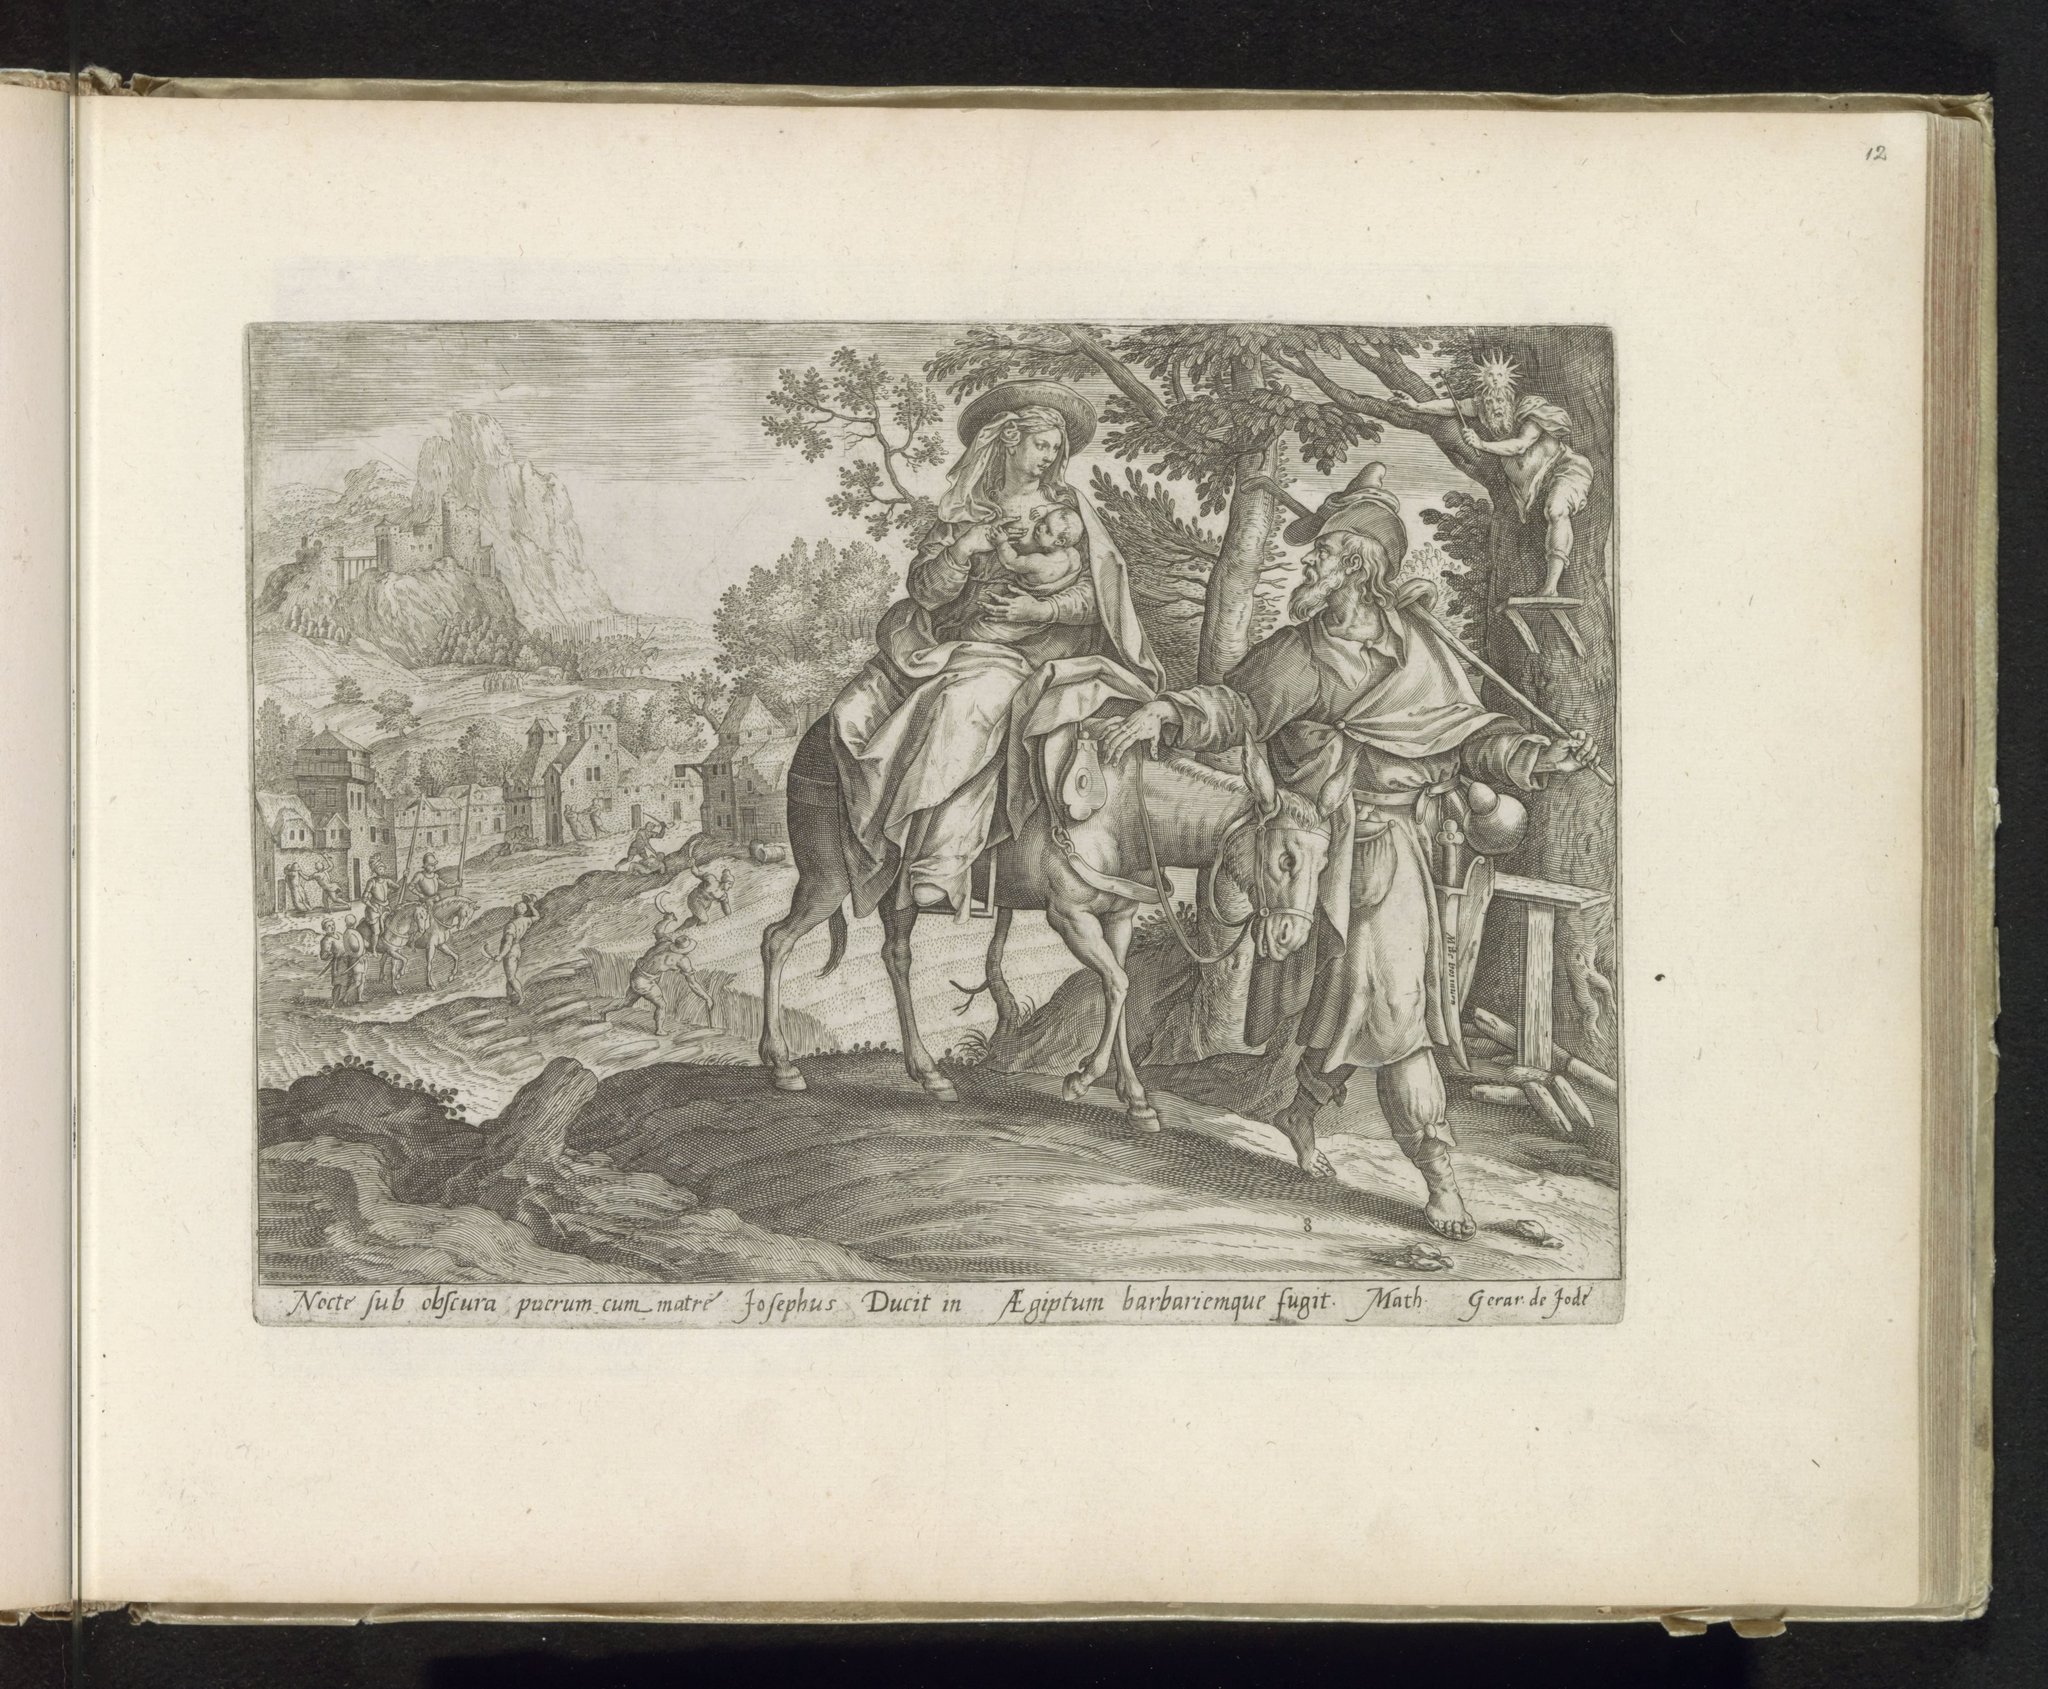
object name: album leaf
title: Vlucht naar Egypte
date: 1585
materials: paper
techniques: engraving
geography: antwerp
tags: flight into egypt and miracles during the journey, soldiers of herod questioning the farmer, who is cutting the ripe wheat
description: Maria geeft Christus de borst, terwijl zij op de ezel zit tijdens de vlucht naar Egypte. Jozef leidt de ezel. Op de achtergrond de kindermoord te Betlehem en de legende van het snel groeiende koren. Enkele soldaten te paard vragen aan een boer of hij een familie voorbij heeft zien gaan. De boer vertelt dat hij het gezin zag toen hij het koren inzaaide. Daarop concluderen de soldaten dat dat erg lang geleden moet zijn en zij staken de zoektocht. Rechts tegen de boom een wijzend mannetje met een zon op zijn hoofd. Wellicht een afgodsbeeld wat weldra van zijn sokkel zal vallen. Onder de voorstelling een verwijzing in het Latijn naar de Bijbeltekst in Mat. 2. Deze prent maakt deel uit van een album.